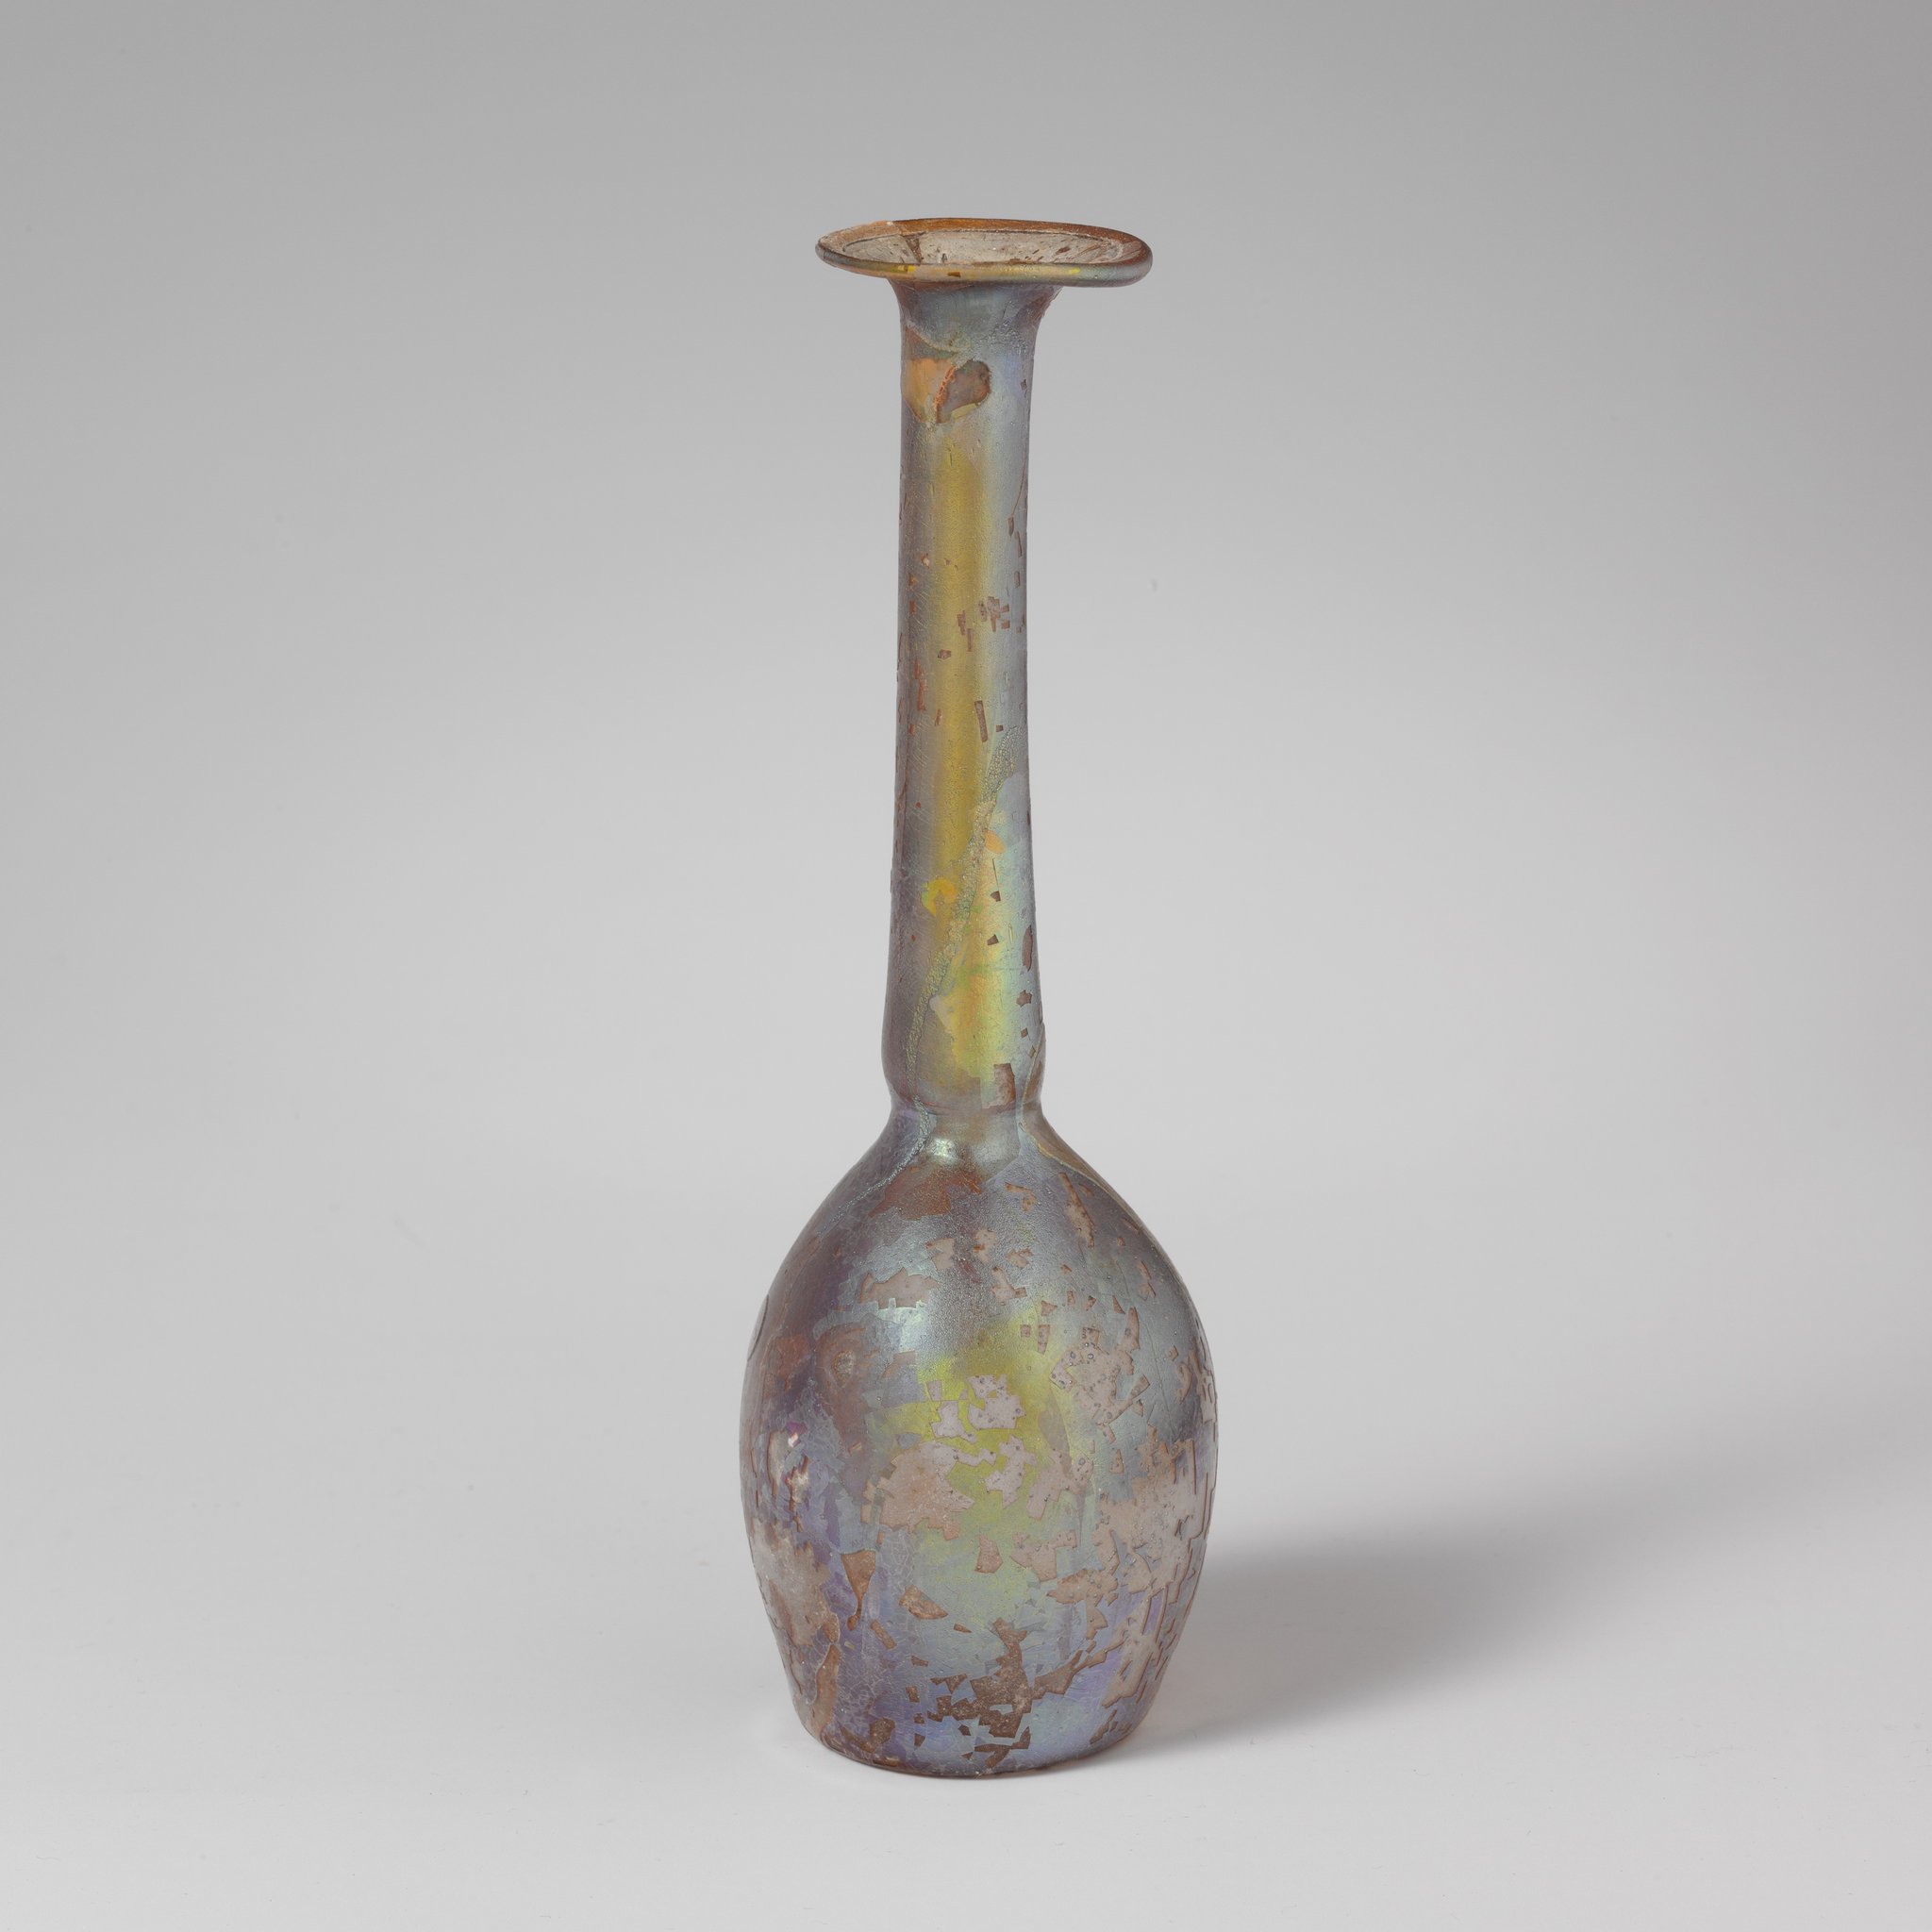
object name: perfume bottle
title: Glass perfume bottle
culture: roman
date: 101-300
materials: glass